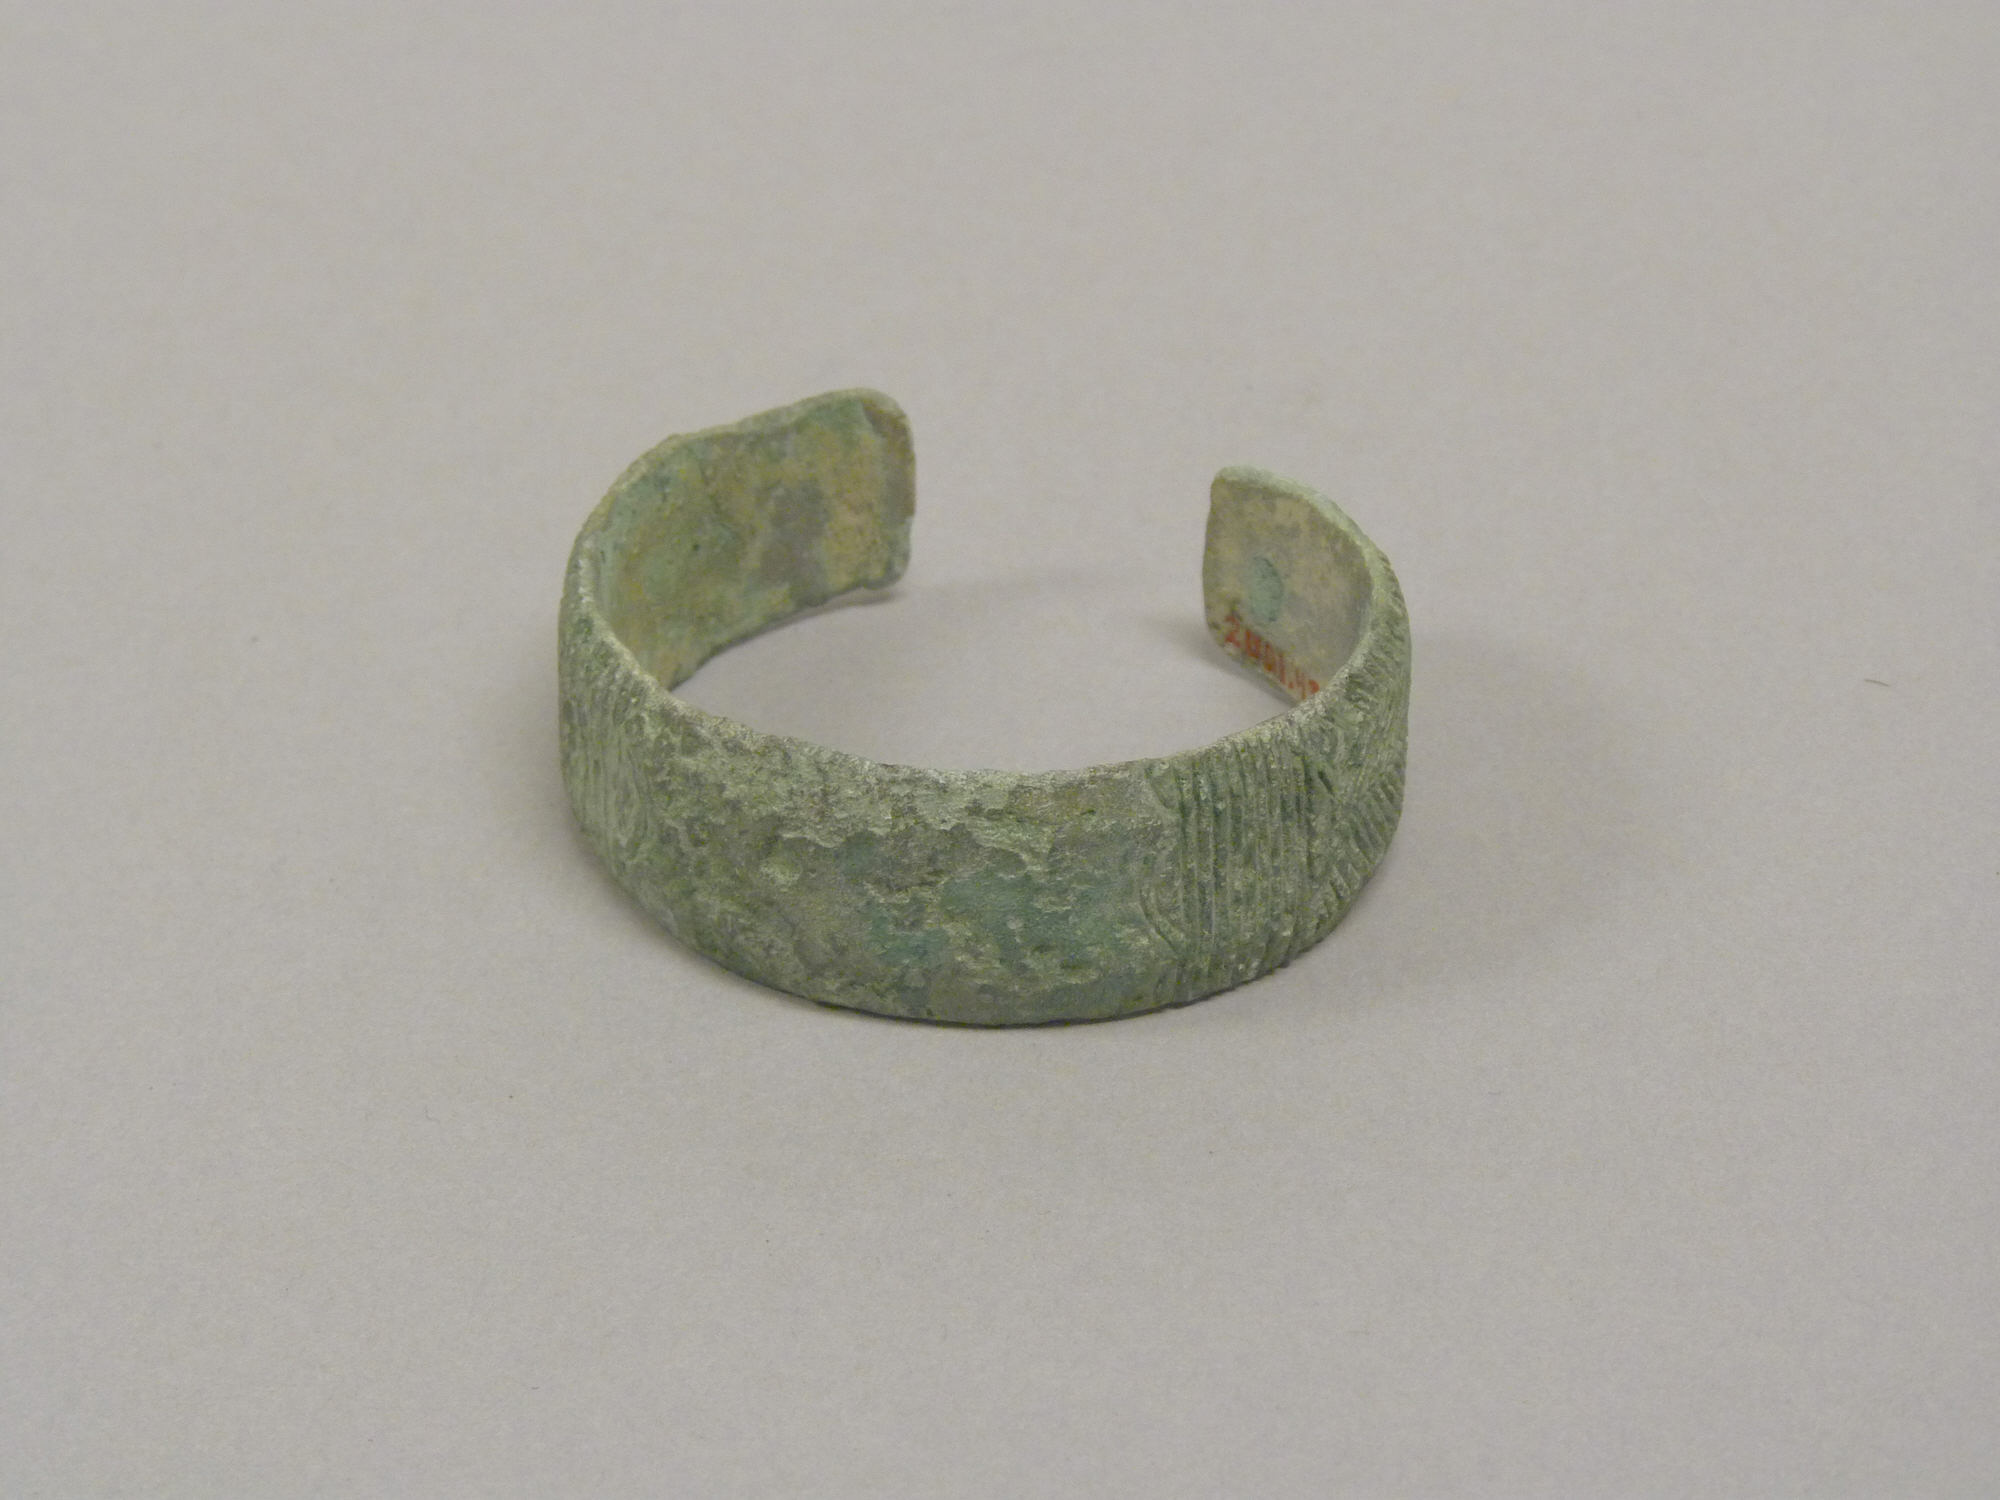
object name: bracelet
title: Open Bracelet with Linear Incising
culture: thai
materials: bronze